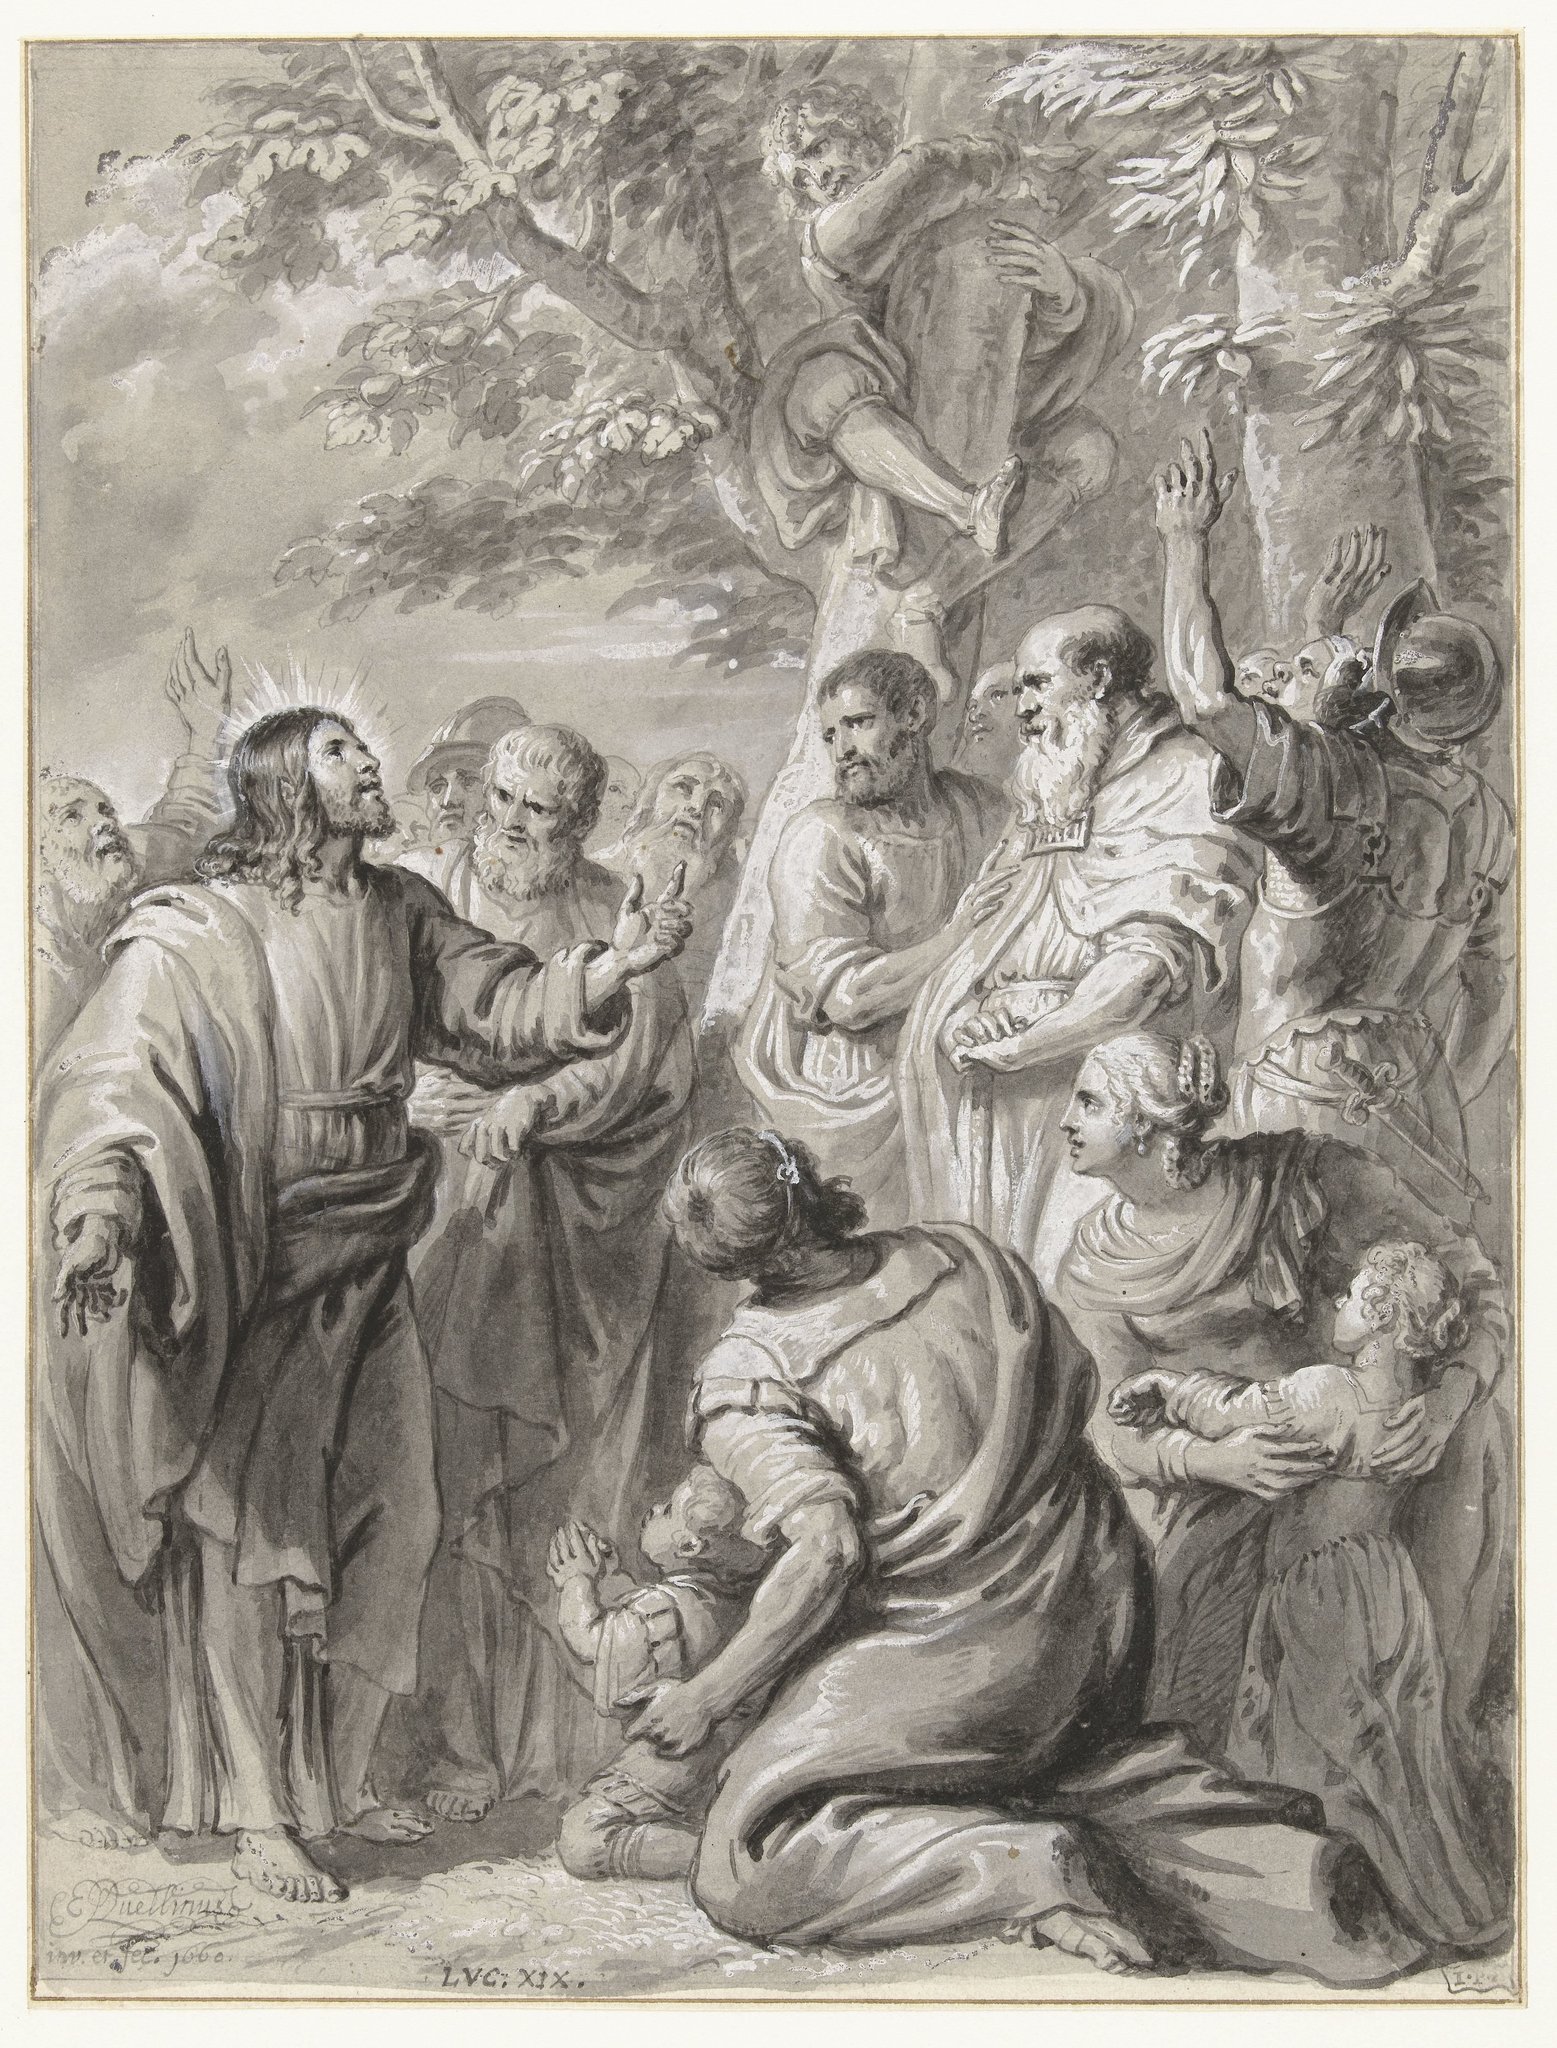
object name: drawing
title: Christus en Zacheüs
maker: erasmus quellinus (ii)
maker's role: draughtsman, print maker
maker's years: 1607-1678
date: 1660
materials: paint, ink, paper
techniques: brush, pen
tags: calling of zacchaeus, who is sitting in a fig-tree (christ passing through jericho)